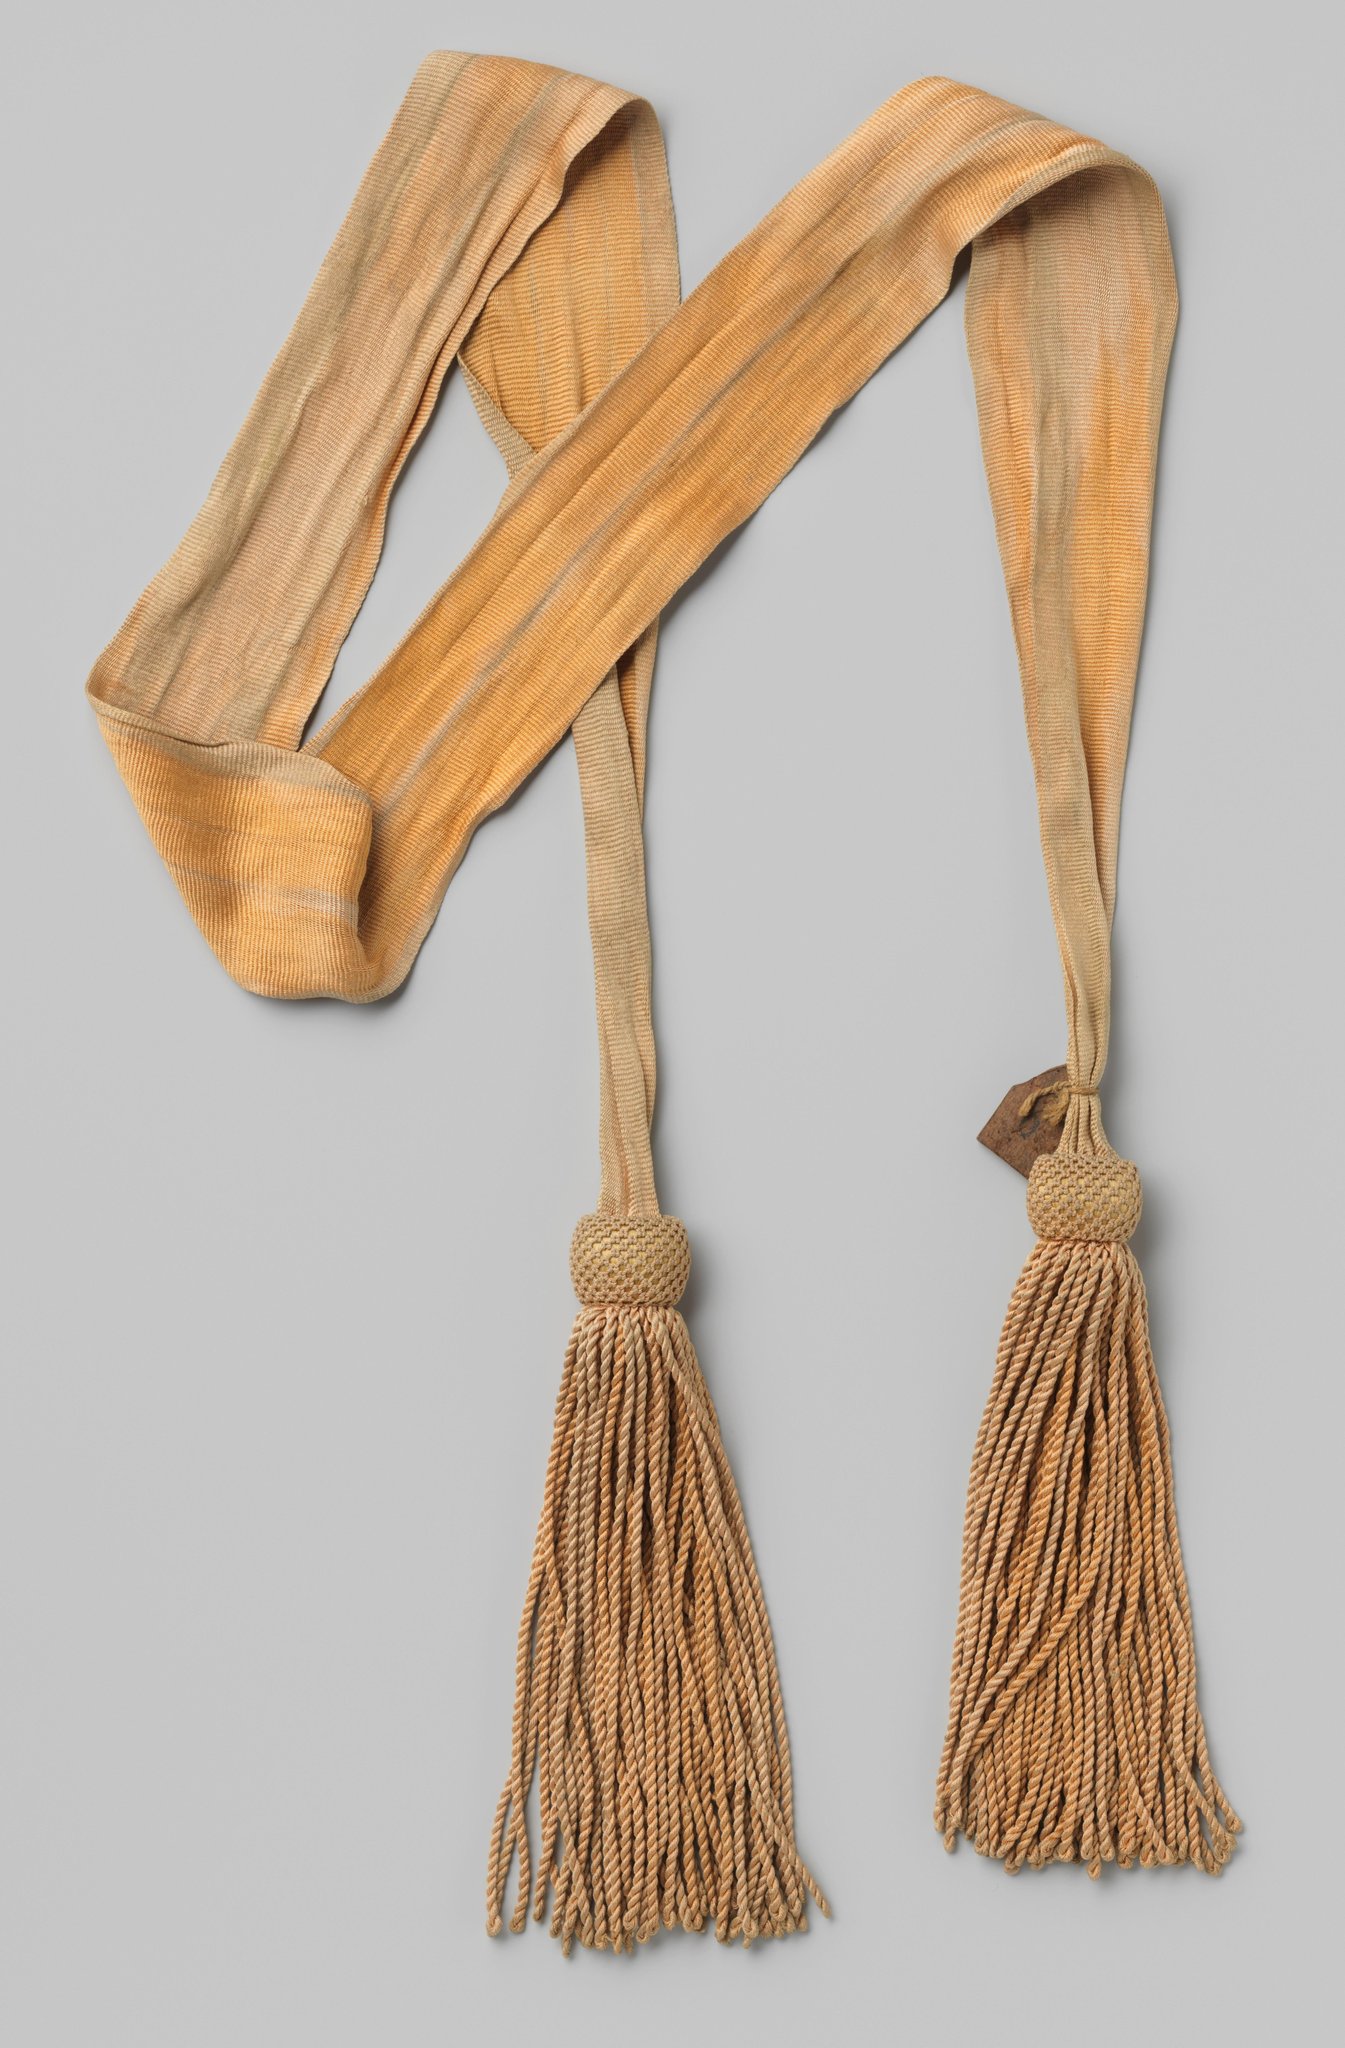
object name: sash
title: Sjerp gedragen door Van Pabst Rutgers, in 1830-32 Majoor Commandant van 1e Bat., 2e Afd. N.H. Schutterij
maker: Anonymous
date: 1800-1830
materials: cord silk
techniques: knotting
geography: netherlands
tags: van pabst rutgers, noord-hollandse schutterij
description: Sjerp van oranje verfletste geknoopte koordzijde 'Egyptisch vlechtwerk'. Een combinatie van de sjerp M1815 met kwasten M1860 (zeldzaam!), met enkele beschadigingen. Aan de sjerp hangen aan de uiteinden twee kwasten van dito zijde, overtrokken met een dito netwerk. Door de kwasten is de sjerp heen getrokken en onder aan de kwast met een bal vastgezet. Uit de kwast ontspringen dito franjes.